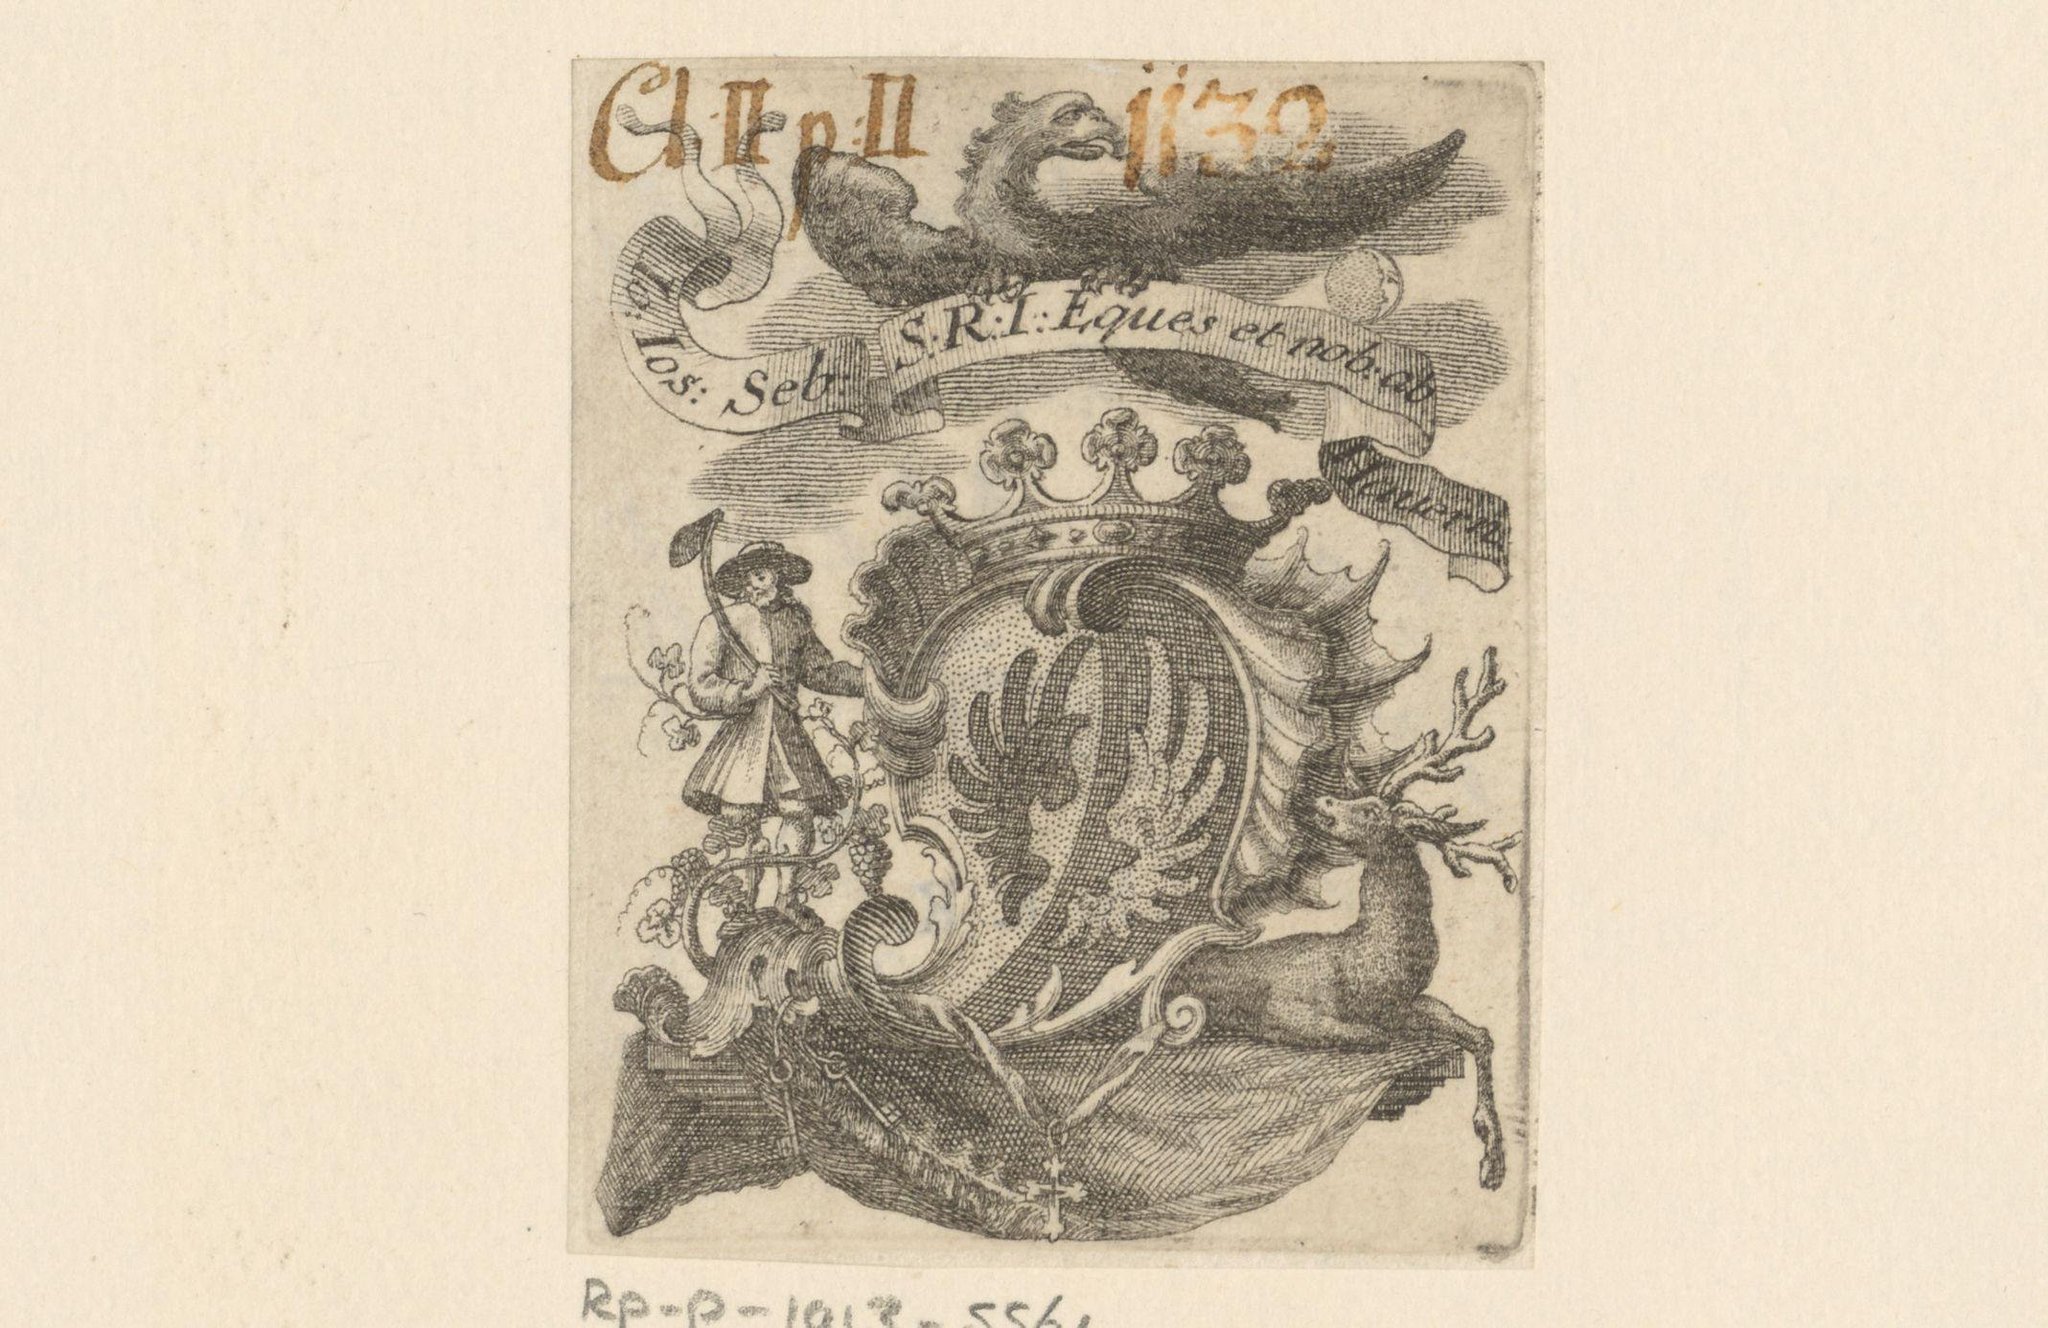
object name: bookplate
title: Ex libris van Io: Ios: Seb: S:R:I: Eques et nob: ab Hauern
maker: Anonymous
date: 1750-1781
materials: paper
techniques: etching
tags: armorial bearing, heraldry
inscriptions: collector's mark: Lugt 2233, collector's mark: Lugt 2760, inscription: ‘A:II p:II ii32’